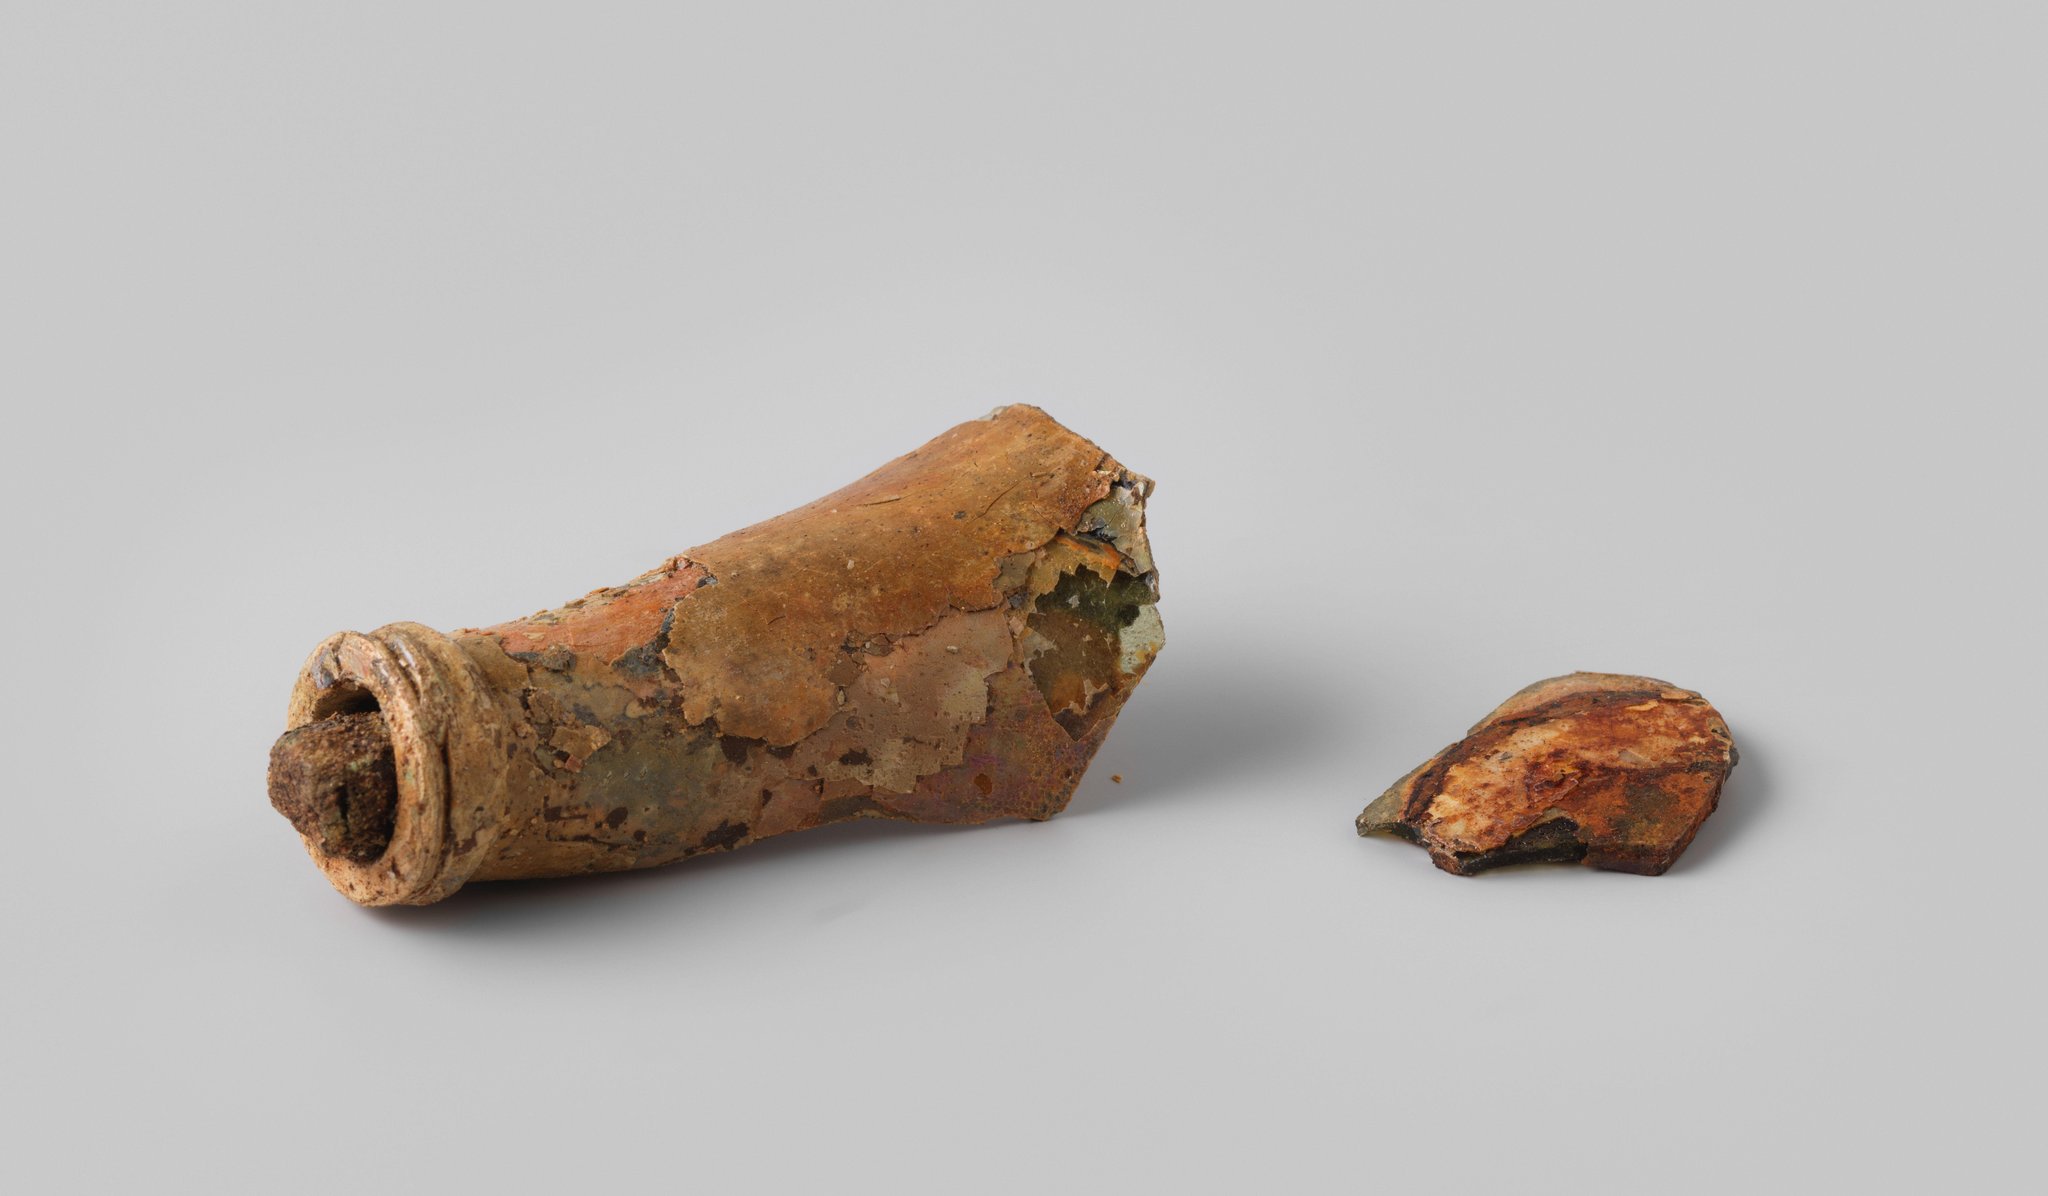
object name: neck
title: Hals met kurk en glasscherf van een wijnfles uit het wrak van de Oost-Indiëvaarder Hollandia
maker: Anonymous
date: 1700-1743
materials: glass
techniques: green glass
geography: netherlands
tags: verenigde oostindische compagnie, hollandia (schip), annet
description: Wine bottle, continental production, neck, onion-shaped bottle or bottle with vertical side; fragm, eroded, f-string rim, projecting cork.